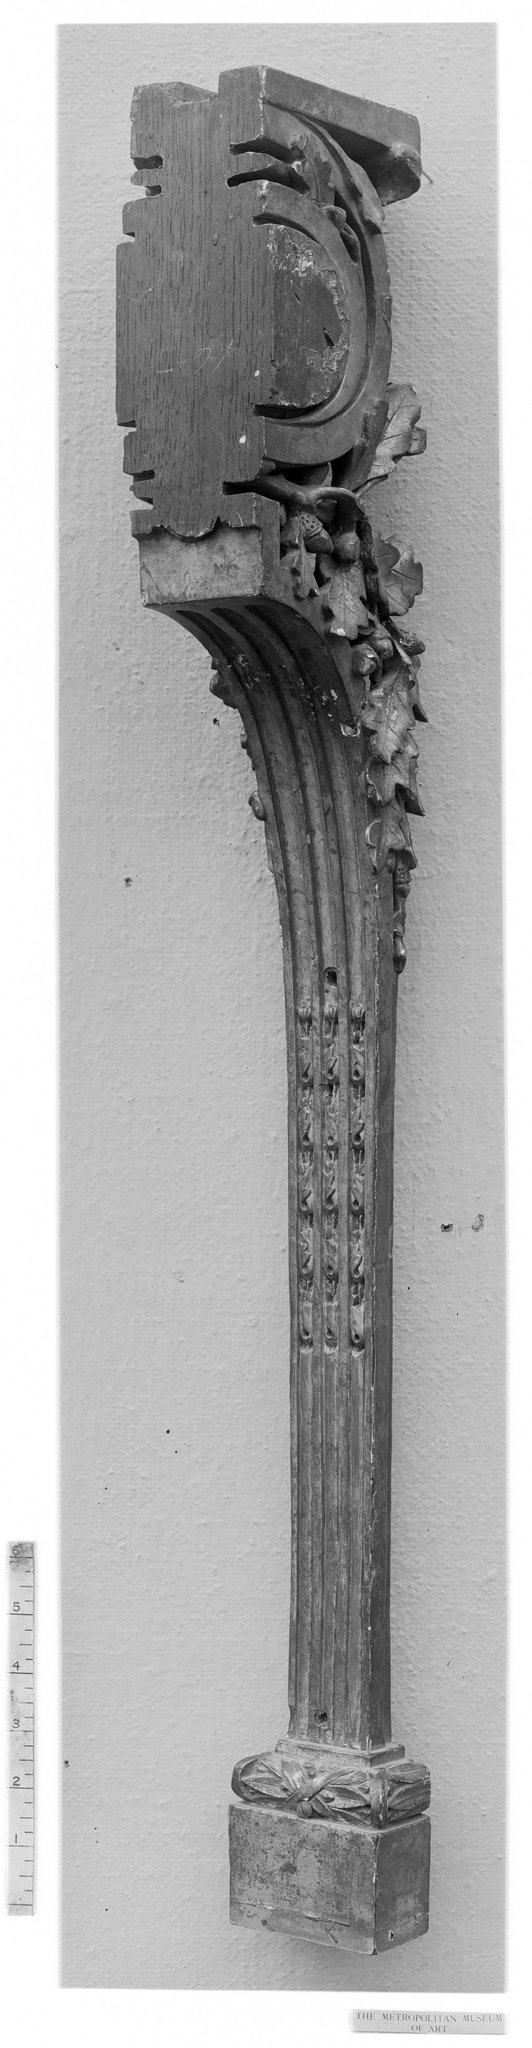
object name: table leg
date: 1701-1800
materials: gilt, wood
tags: leaves